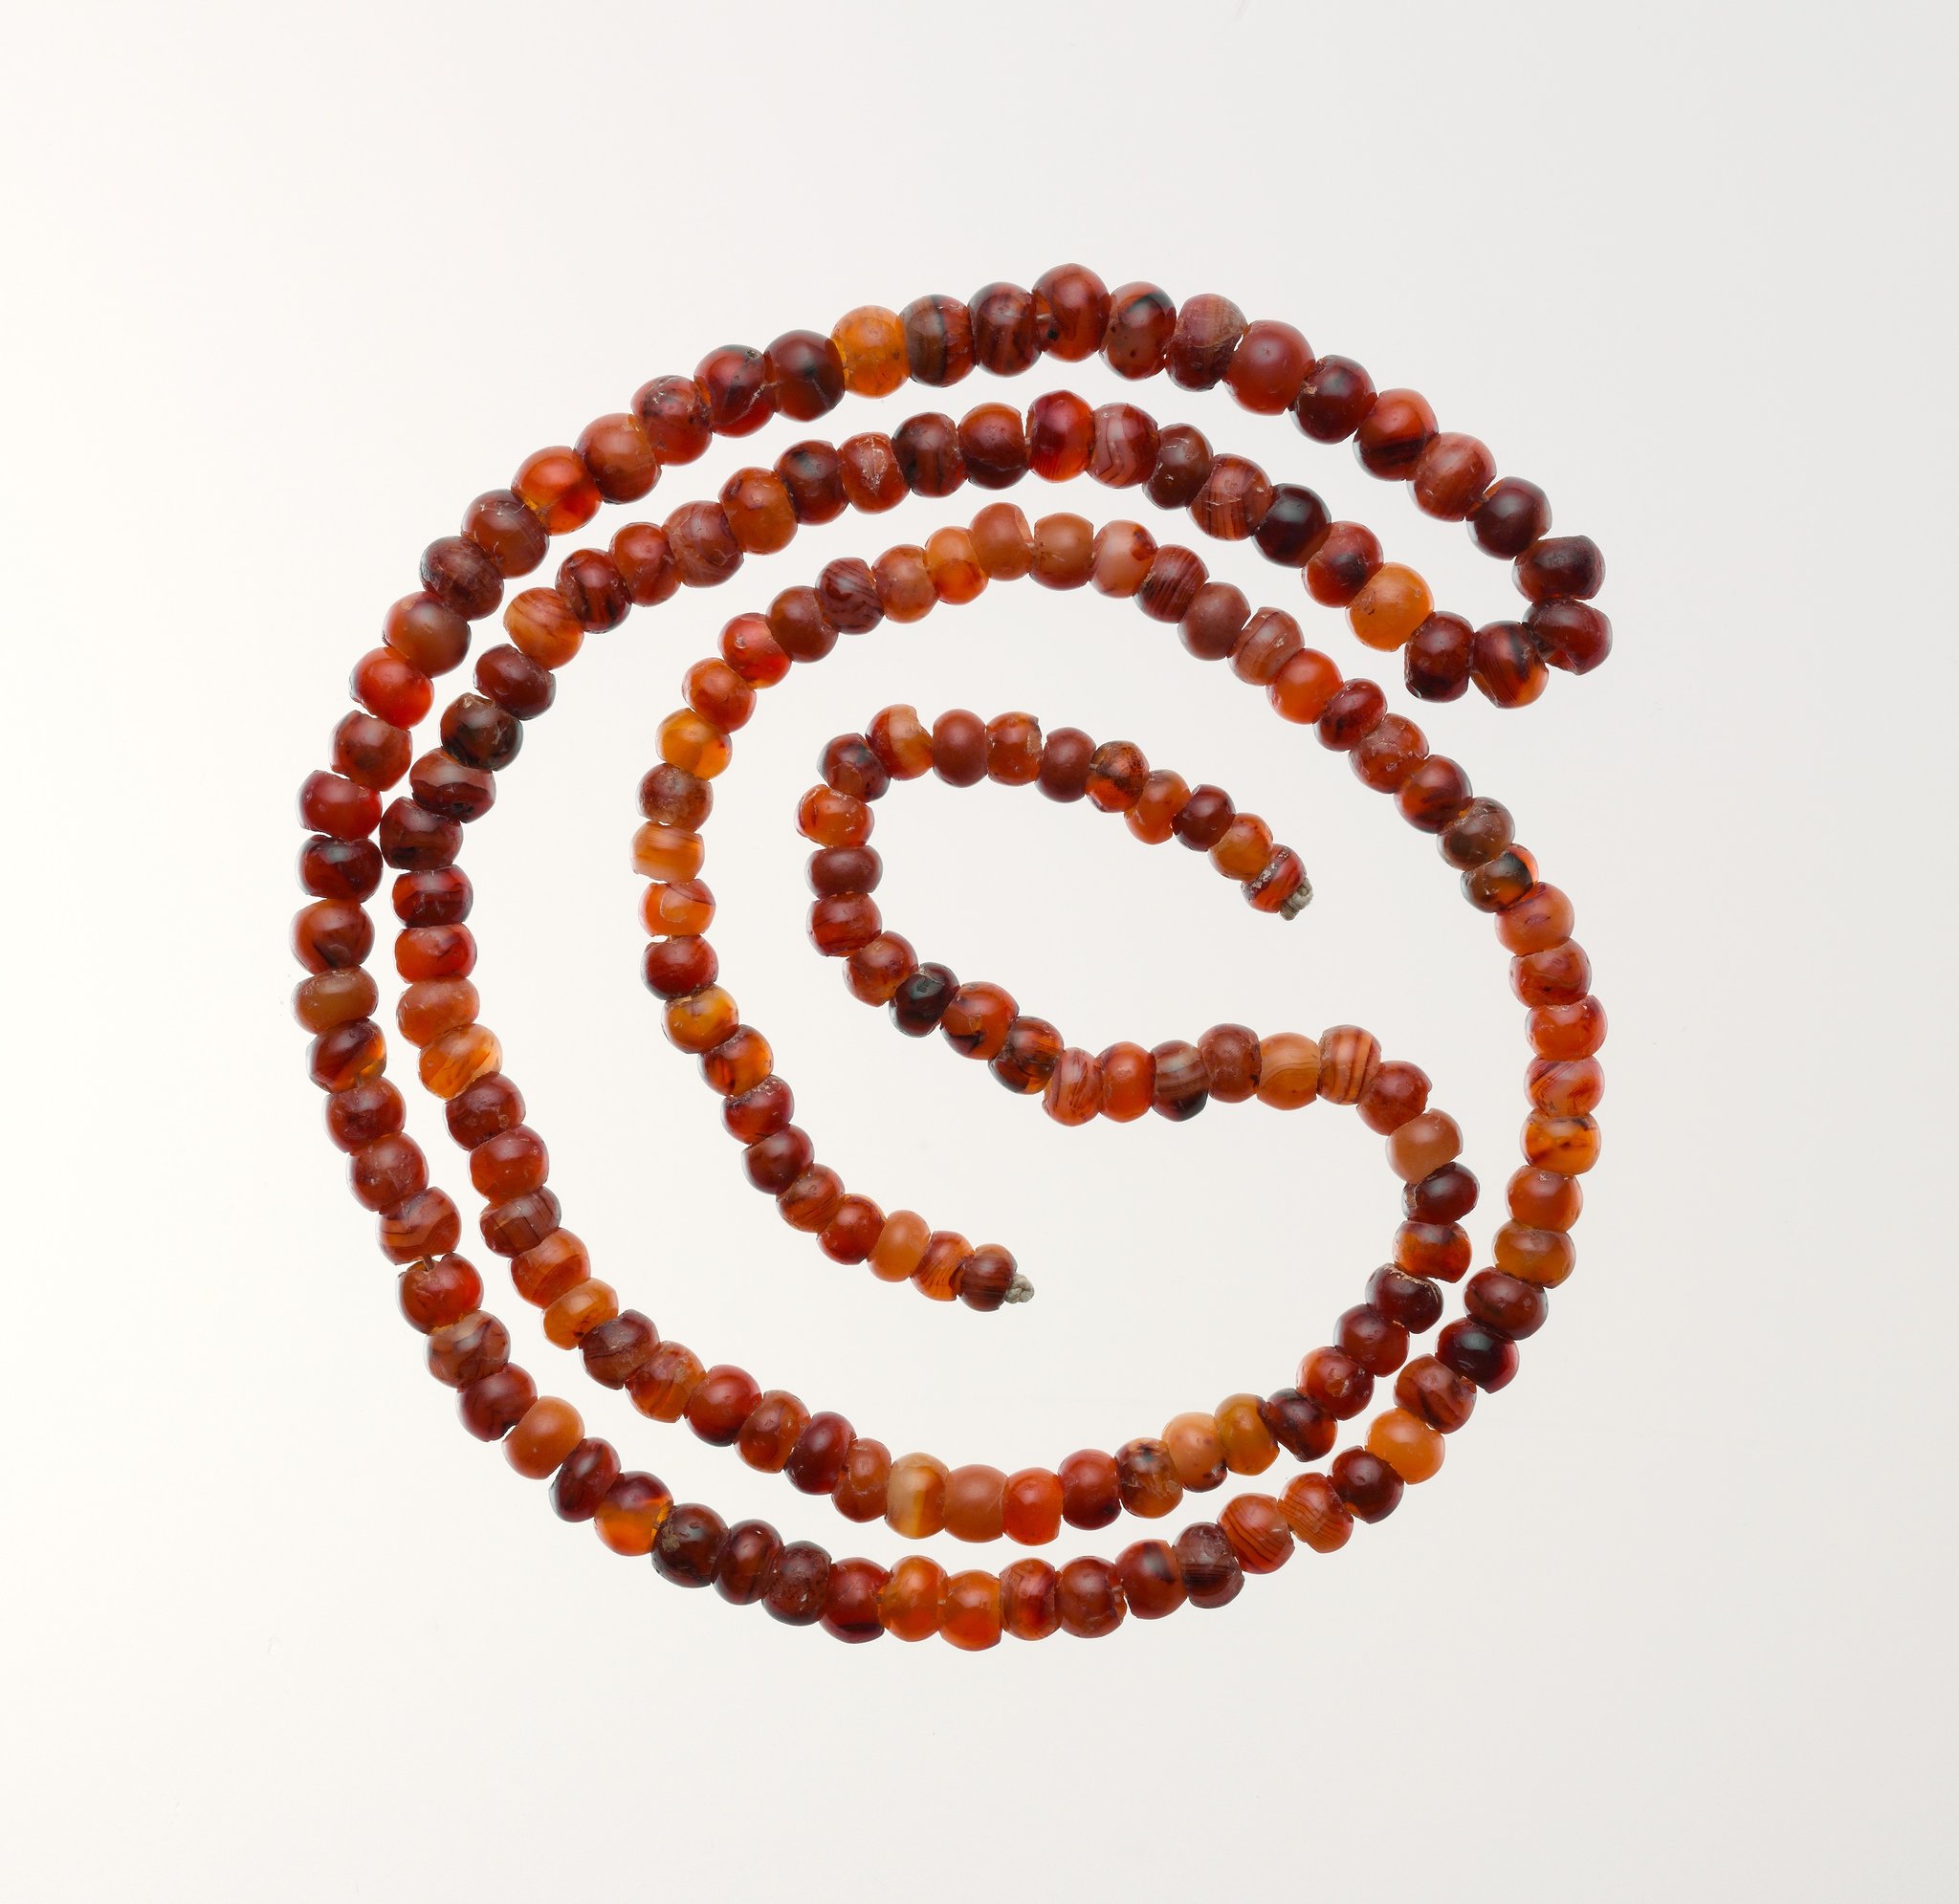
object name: bead, found scattered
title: Hepy, 168 of orignally 72 loose beads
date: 1950-1885 BCE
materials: gemstone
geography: egypt